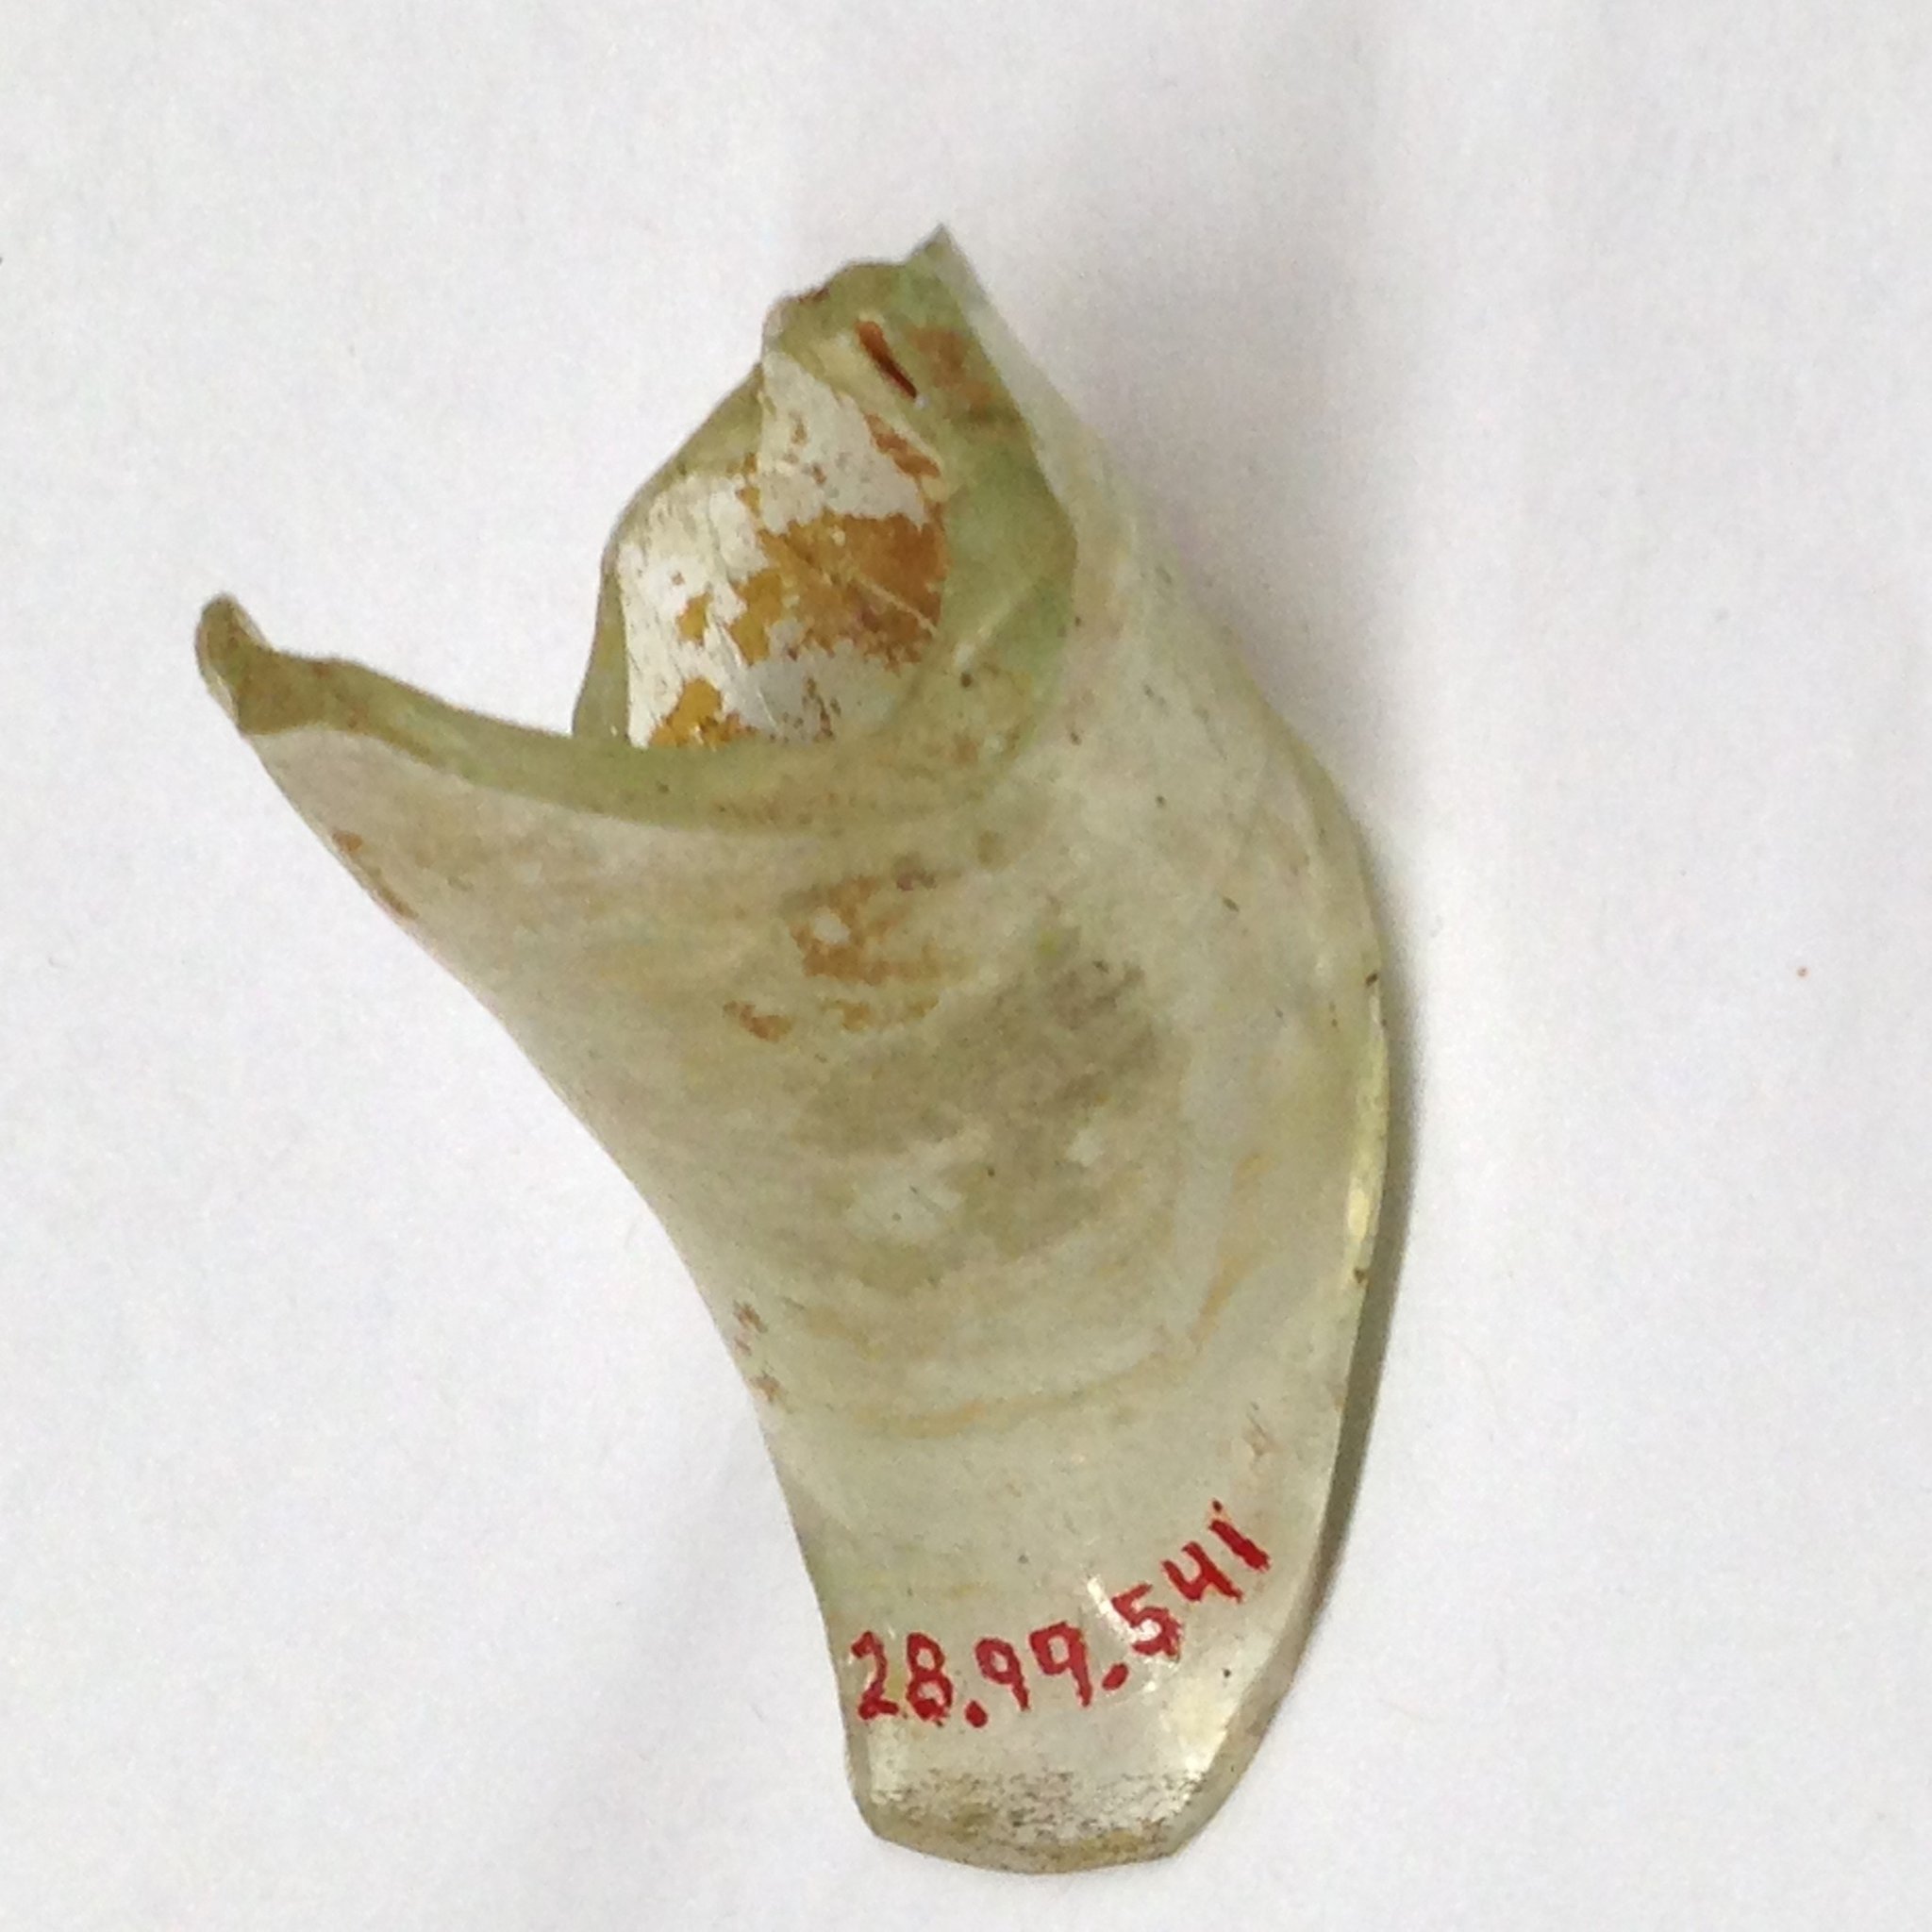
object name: fragment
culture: european or middle eastern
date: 1150-1250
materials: ceramic, glass